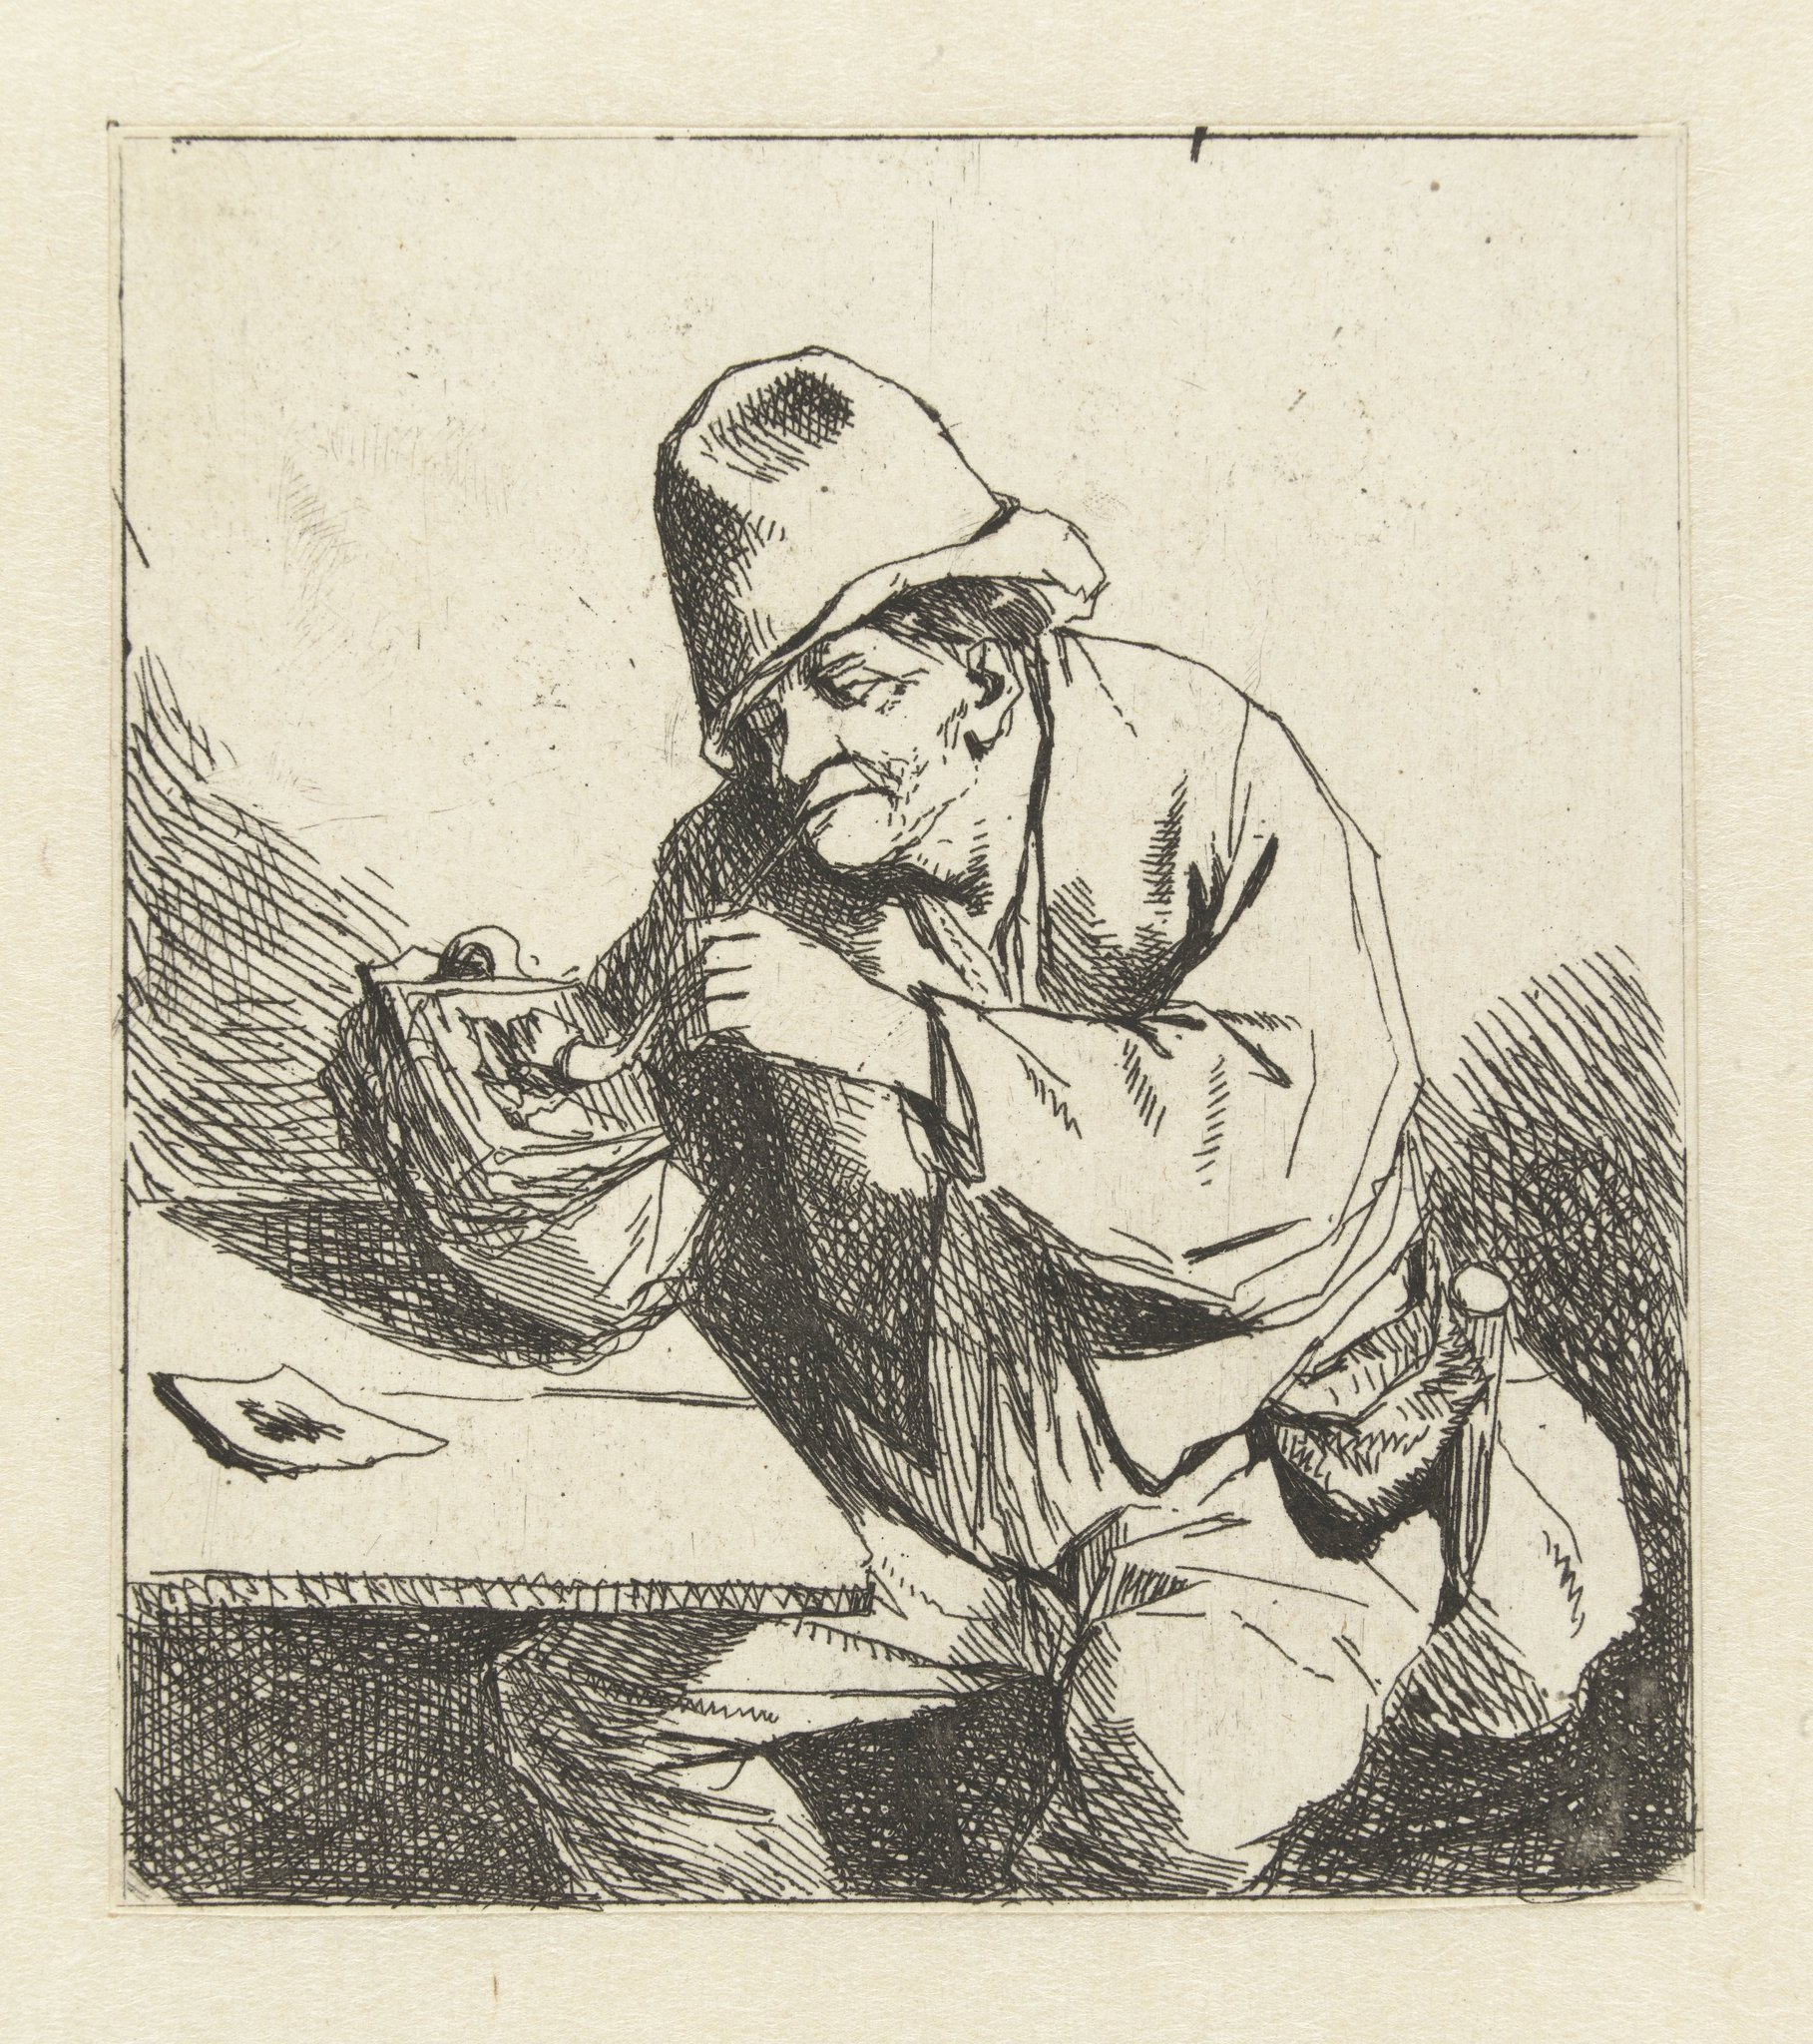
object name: print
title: Zittende man steekt pijp aan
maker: cornelis pietersz. bega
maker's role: draughtsman, painter, print maker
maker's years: 1631-1664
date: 1642-1664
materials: paper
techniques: etching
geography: netherlands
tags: pipe ~ tobacco, male sex; man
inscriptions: collector's mark: Lugt 240